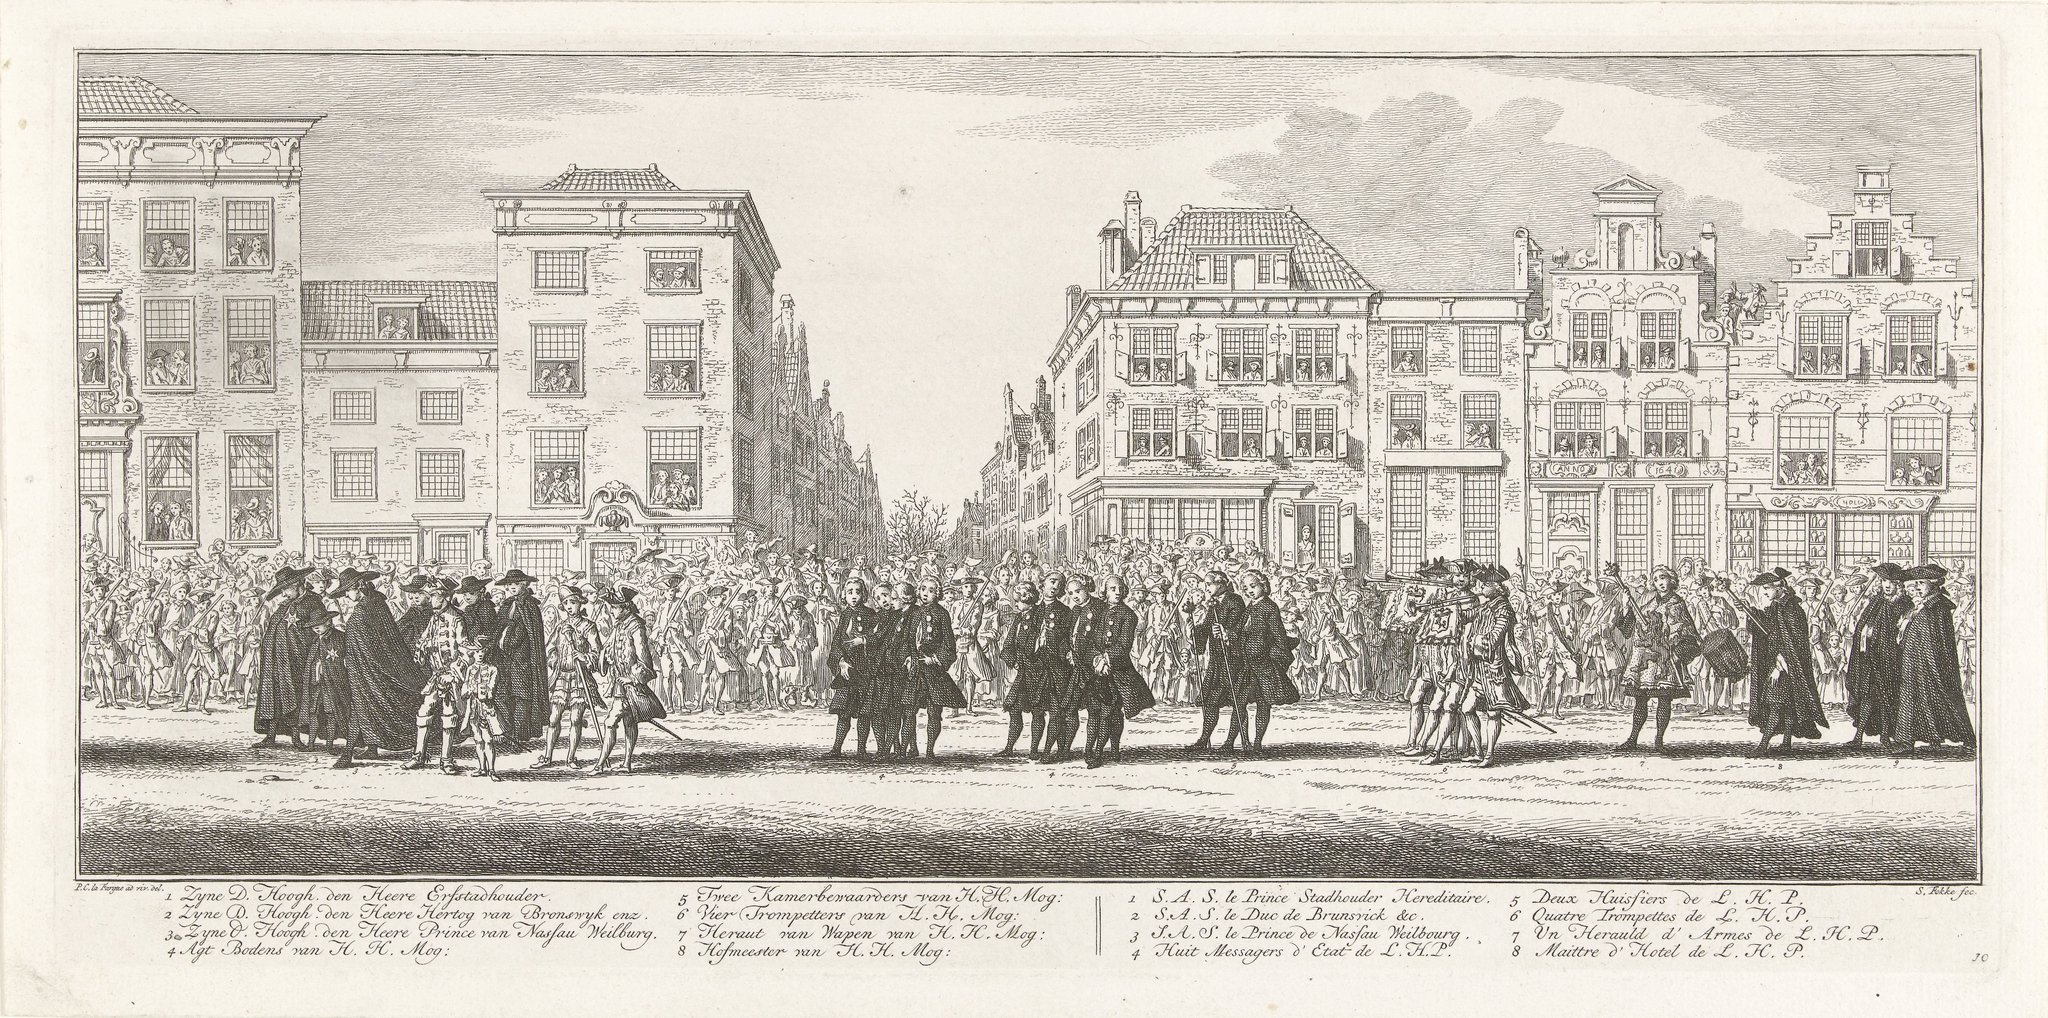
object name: print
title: Lijkstoet van prinses Anna van Hannover te Delft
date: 1759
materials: paper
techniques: engraving, etching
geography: northern netherlands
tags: william v (prince of orange), anna van hannover, cortege, funeral procession, delft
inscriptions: collector's mark: Lugt 2228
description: Prins Willem V met familie gevolgd door personeel van de Staten-Generaal. Onderdeel van een serie van 16 platen plus een gedrukte beschrijving van de lijkstatie van de op 23 februari 1759 te Delft begraven prinses Anna van Hannover. Genummerd rechtsonder: 10.